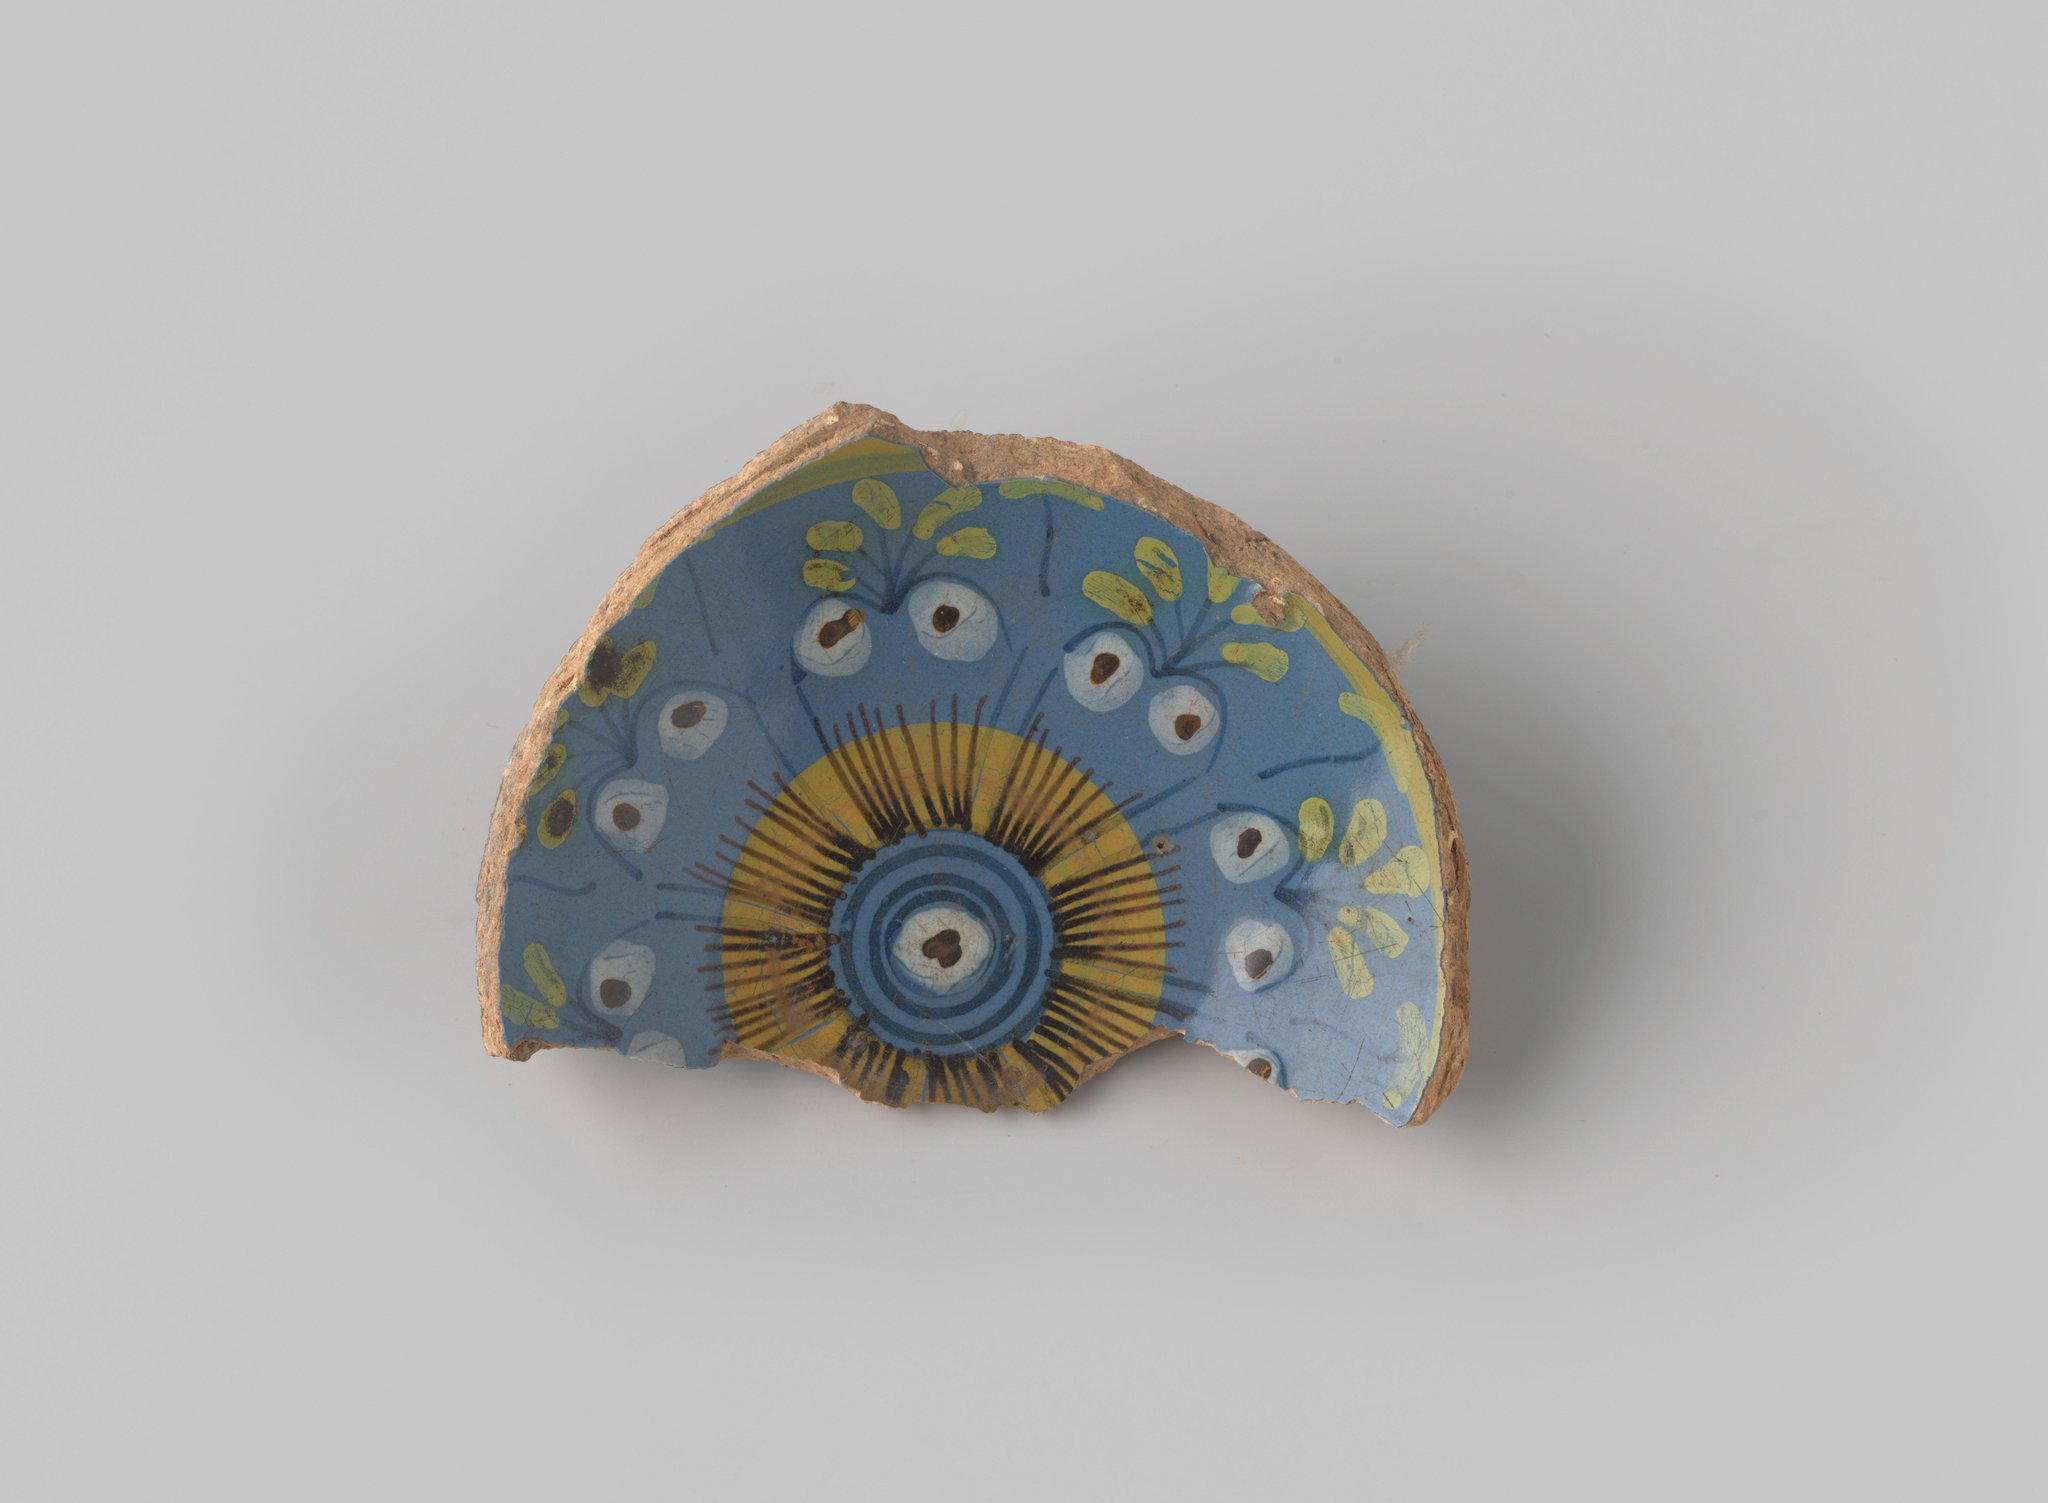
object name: fragment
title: Scherf van rossigbakkend aardewerk, met voetring, aan de voorzijde voorzien van blauw glazuur, met op het plat een schildering met gestileerde bloemvormen in bruin, blauw, groen, geel en wit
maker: Anonymous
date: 1600-1650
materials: earthenware, glaze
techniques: maiolica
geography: northern netherlands